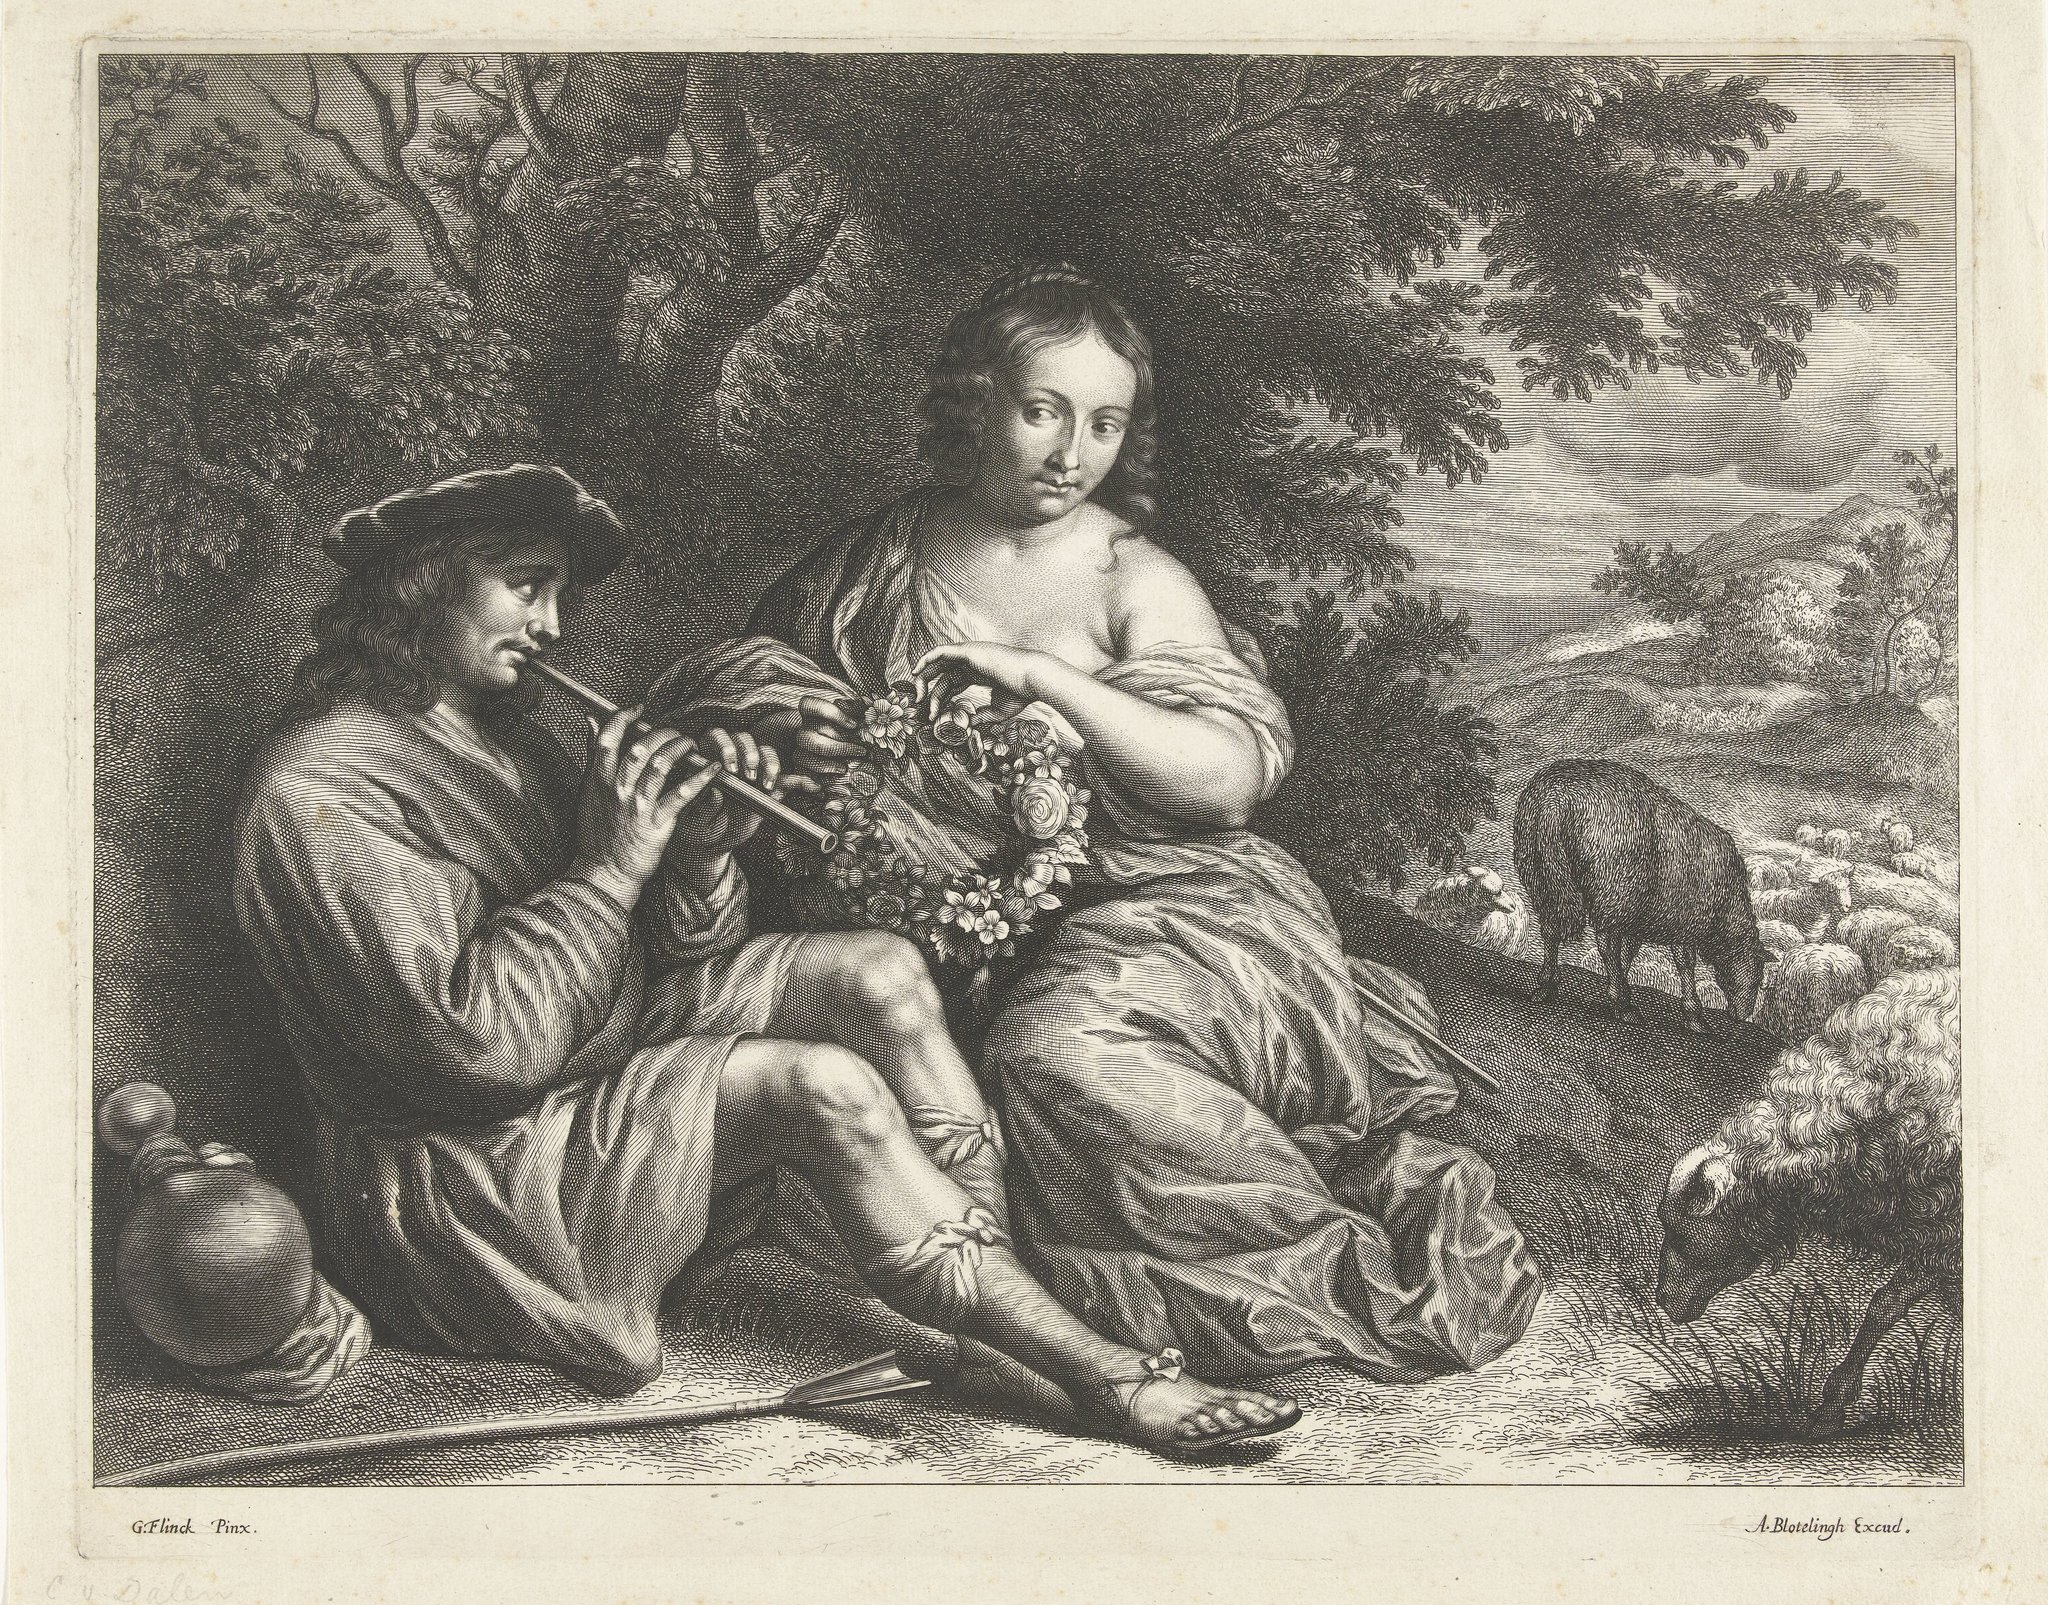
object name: print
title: Verliefd herderspaar onder een boom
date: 1655-1690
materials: paper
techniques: engraving, etching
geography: amsterdam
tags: herding, herdsman, herdswoman, shepherd, shepherdess, cowherd, etc., pastorals, arcadian scenes, flute, aulos, tibia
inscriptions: collector's mark: Lugt 240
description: Een herder en een herderin zitten onder een boom. De herder speelt op de fluit, de herderin houdt een bloemenkrans in haar handen. De kudde schapen graast op de achtergrond.